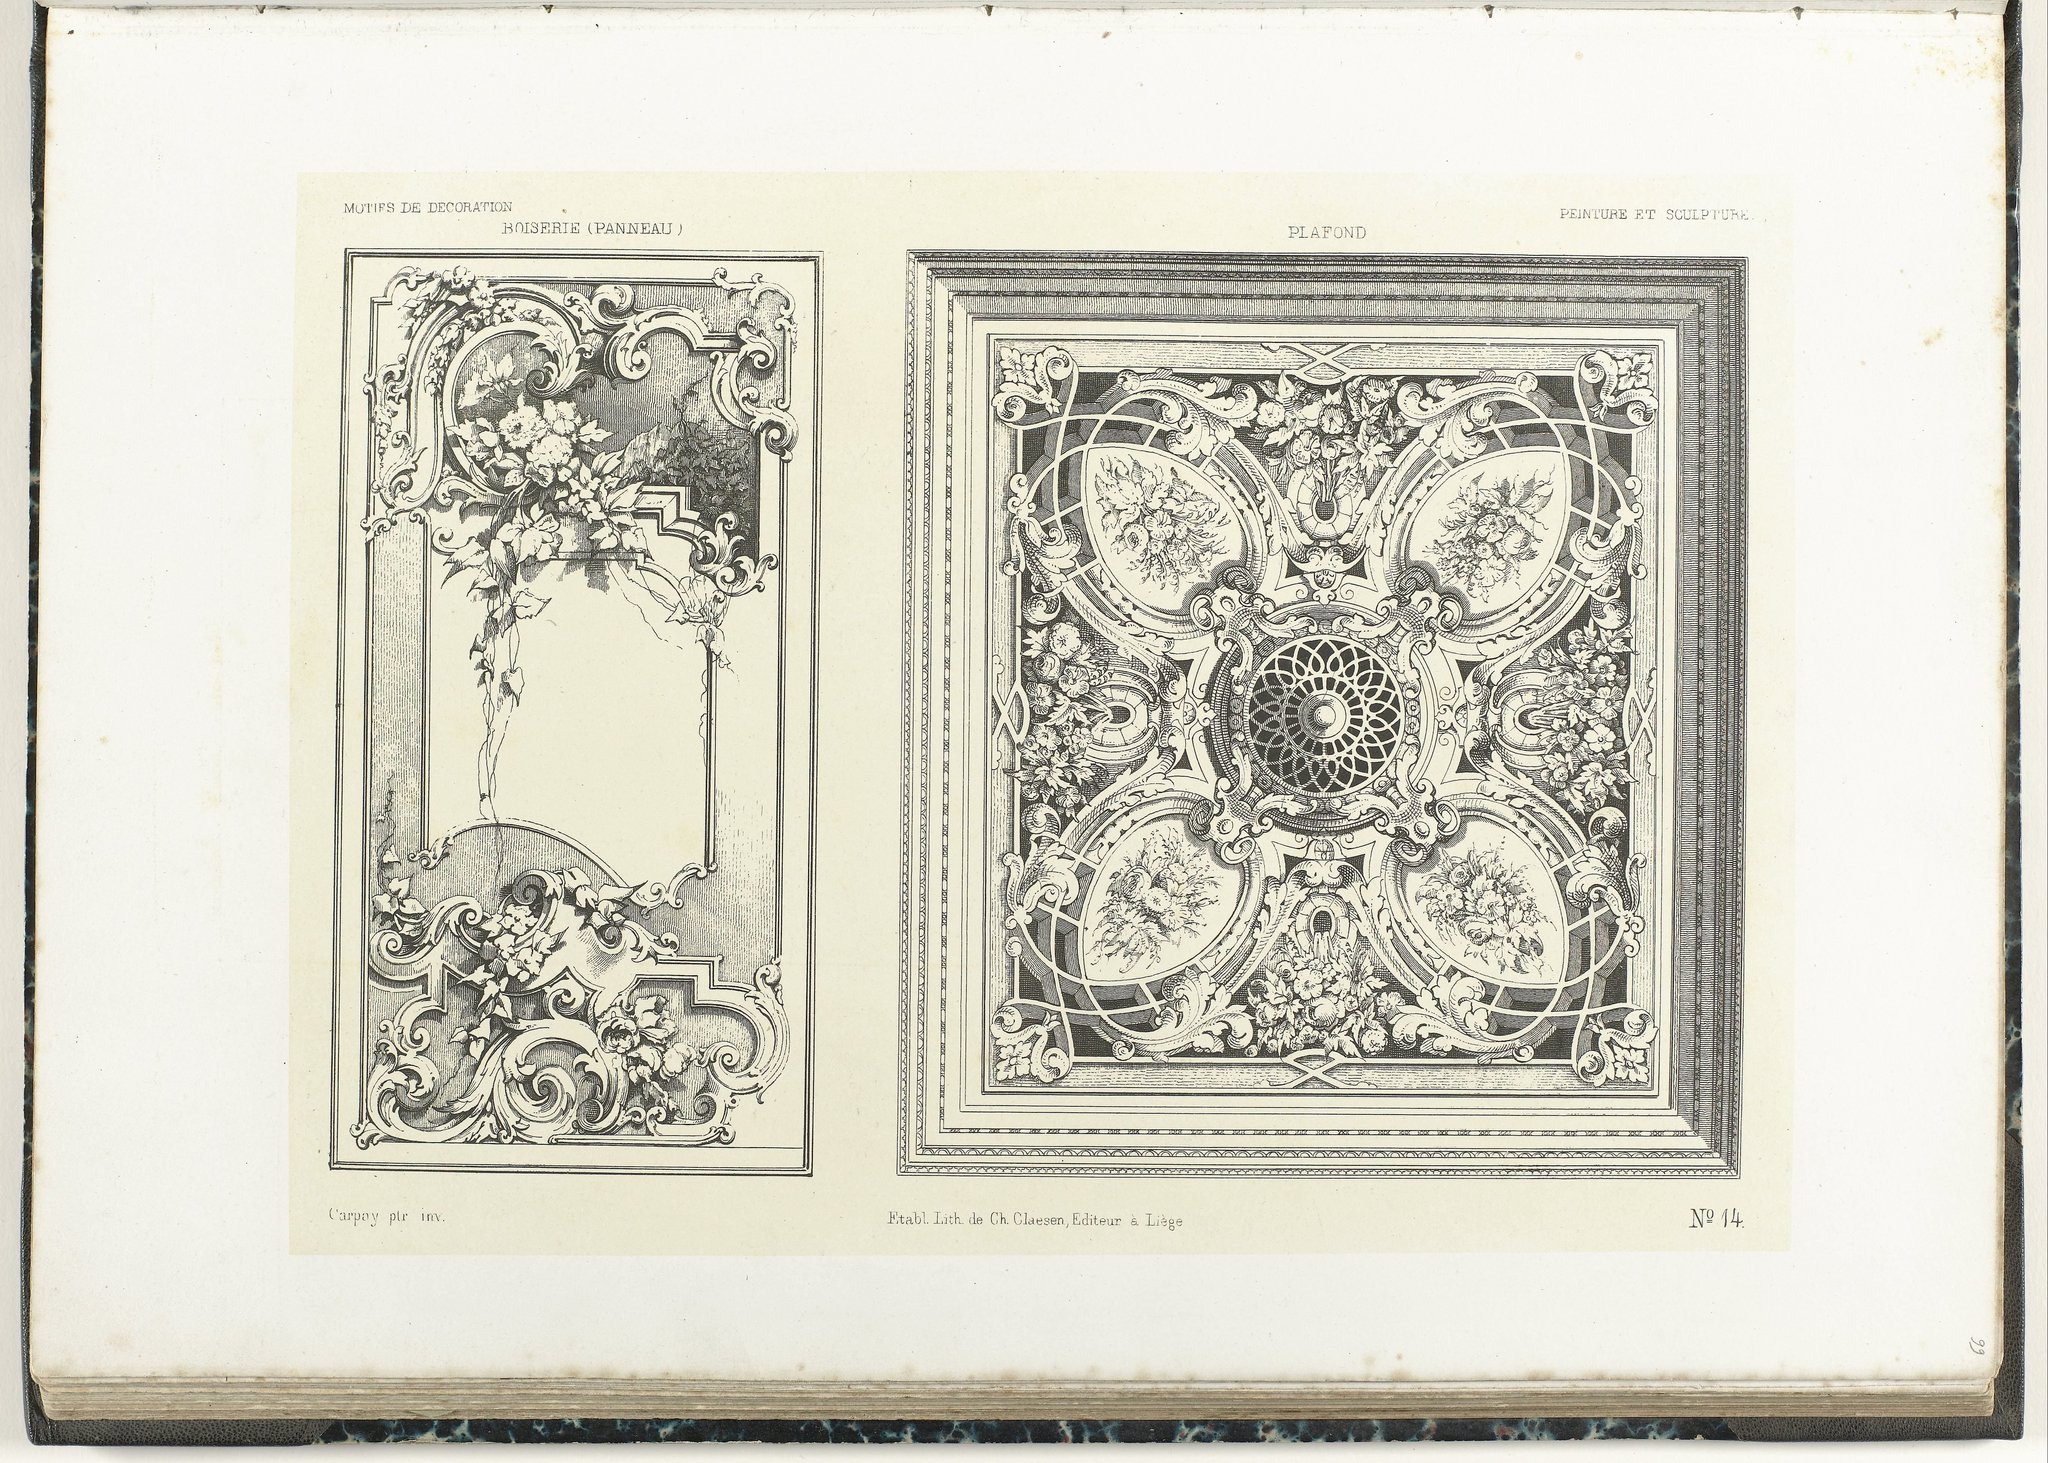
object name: print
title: Boiserie (panneaux) / Plafond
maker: paul-joseph carpay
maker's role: painter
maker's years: 1822-1892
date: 1866-1900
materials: paper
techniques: tone lithography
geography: liège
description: Links een paneel met voluten van bladranken waar bloemen en bladeren overheen groeien, rechts een plafond met vier ovalen die uitlopen in een punt met bloemen erin. Linksboven staat vermeld: Motifs de décoration, rechtsboven: Peinture et sculpture, rechtsonder: N° 14.